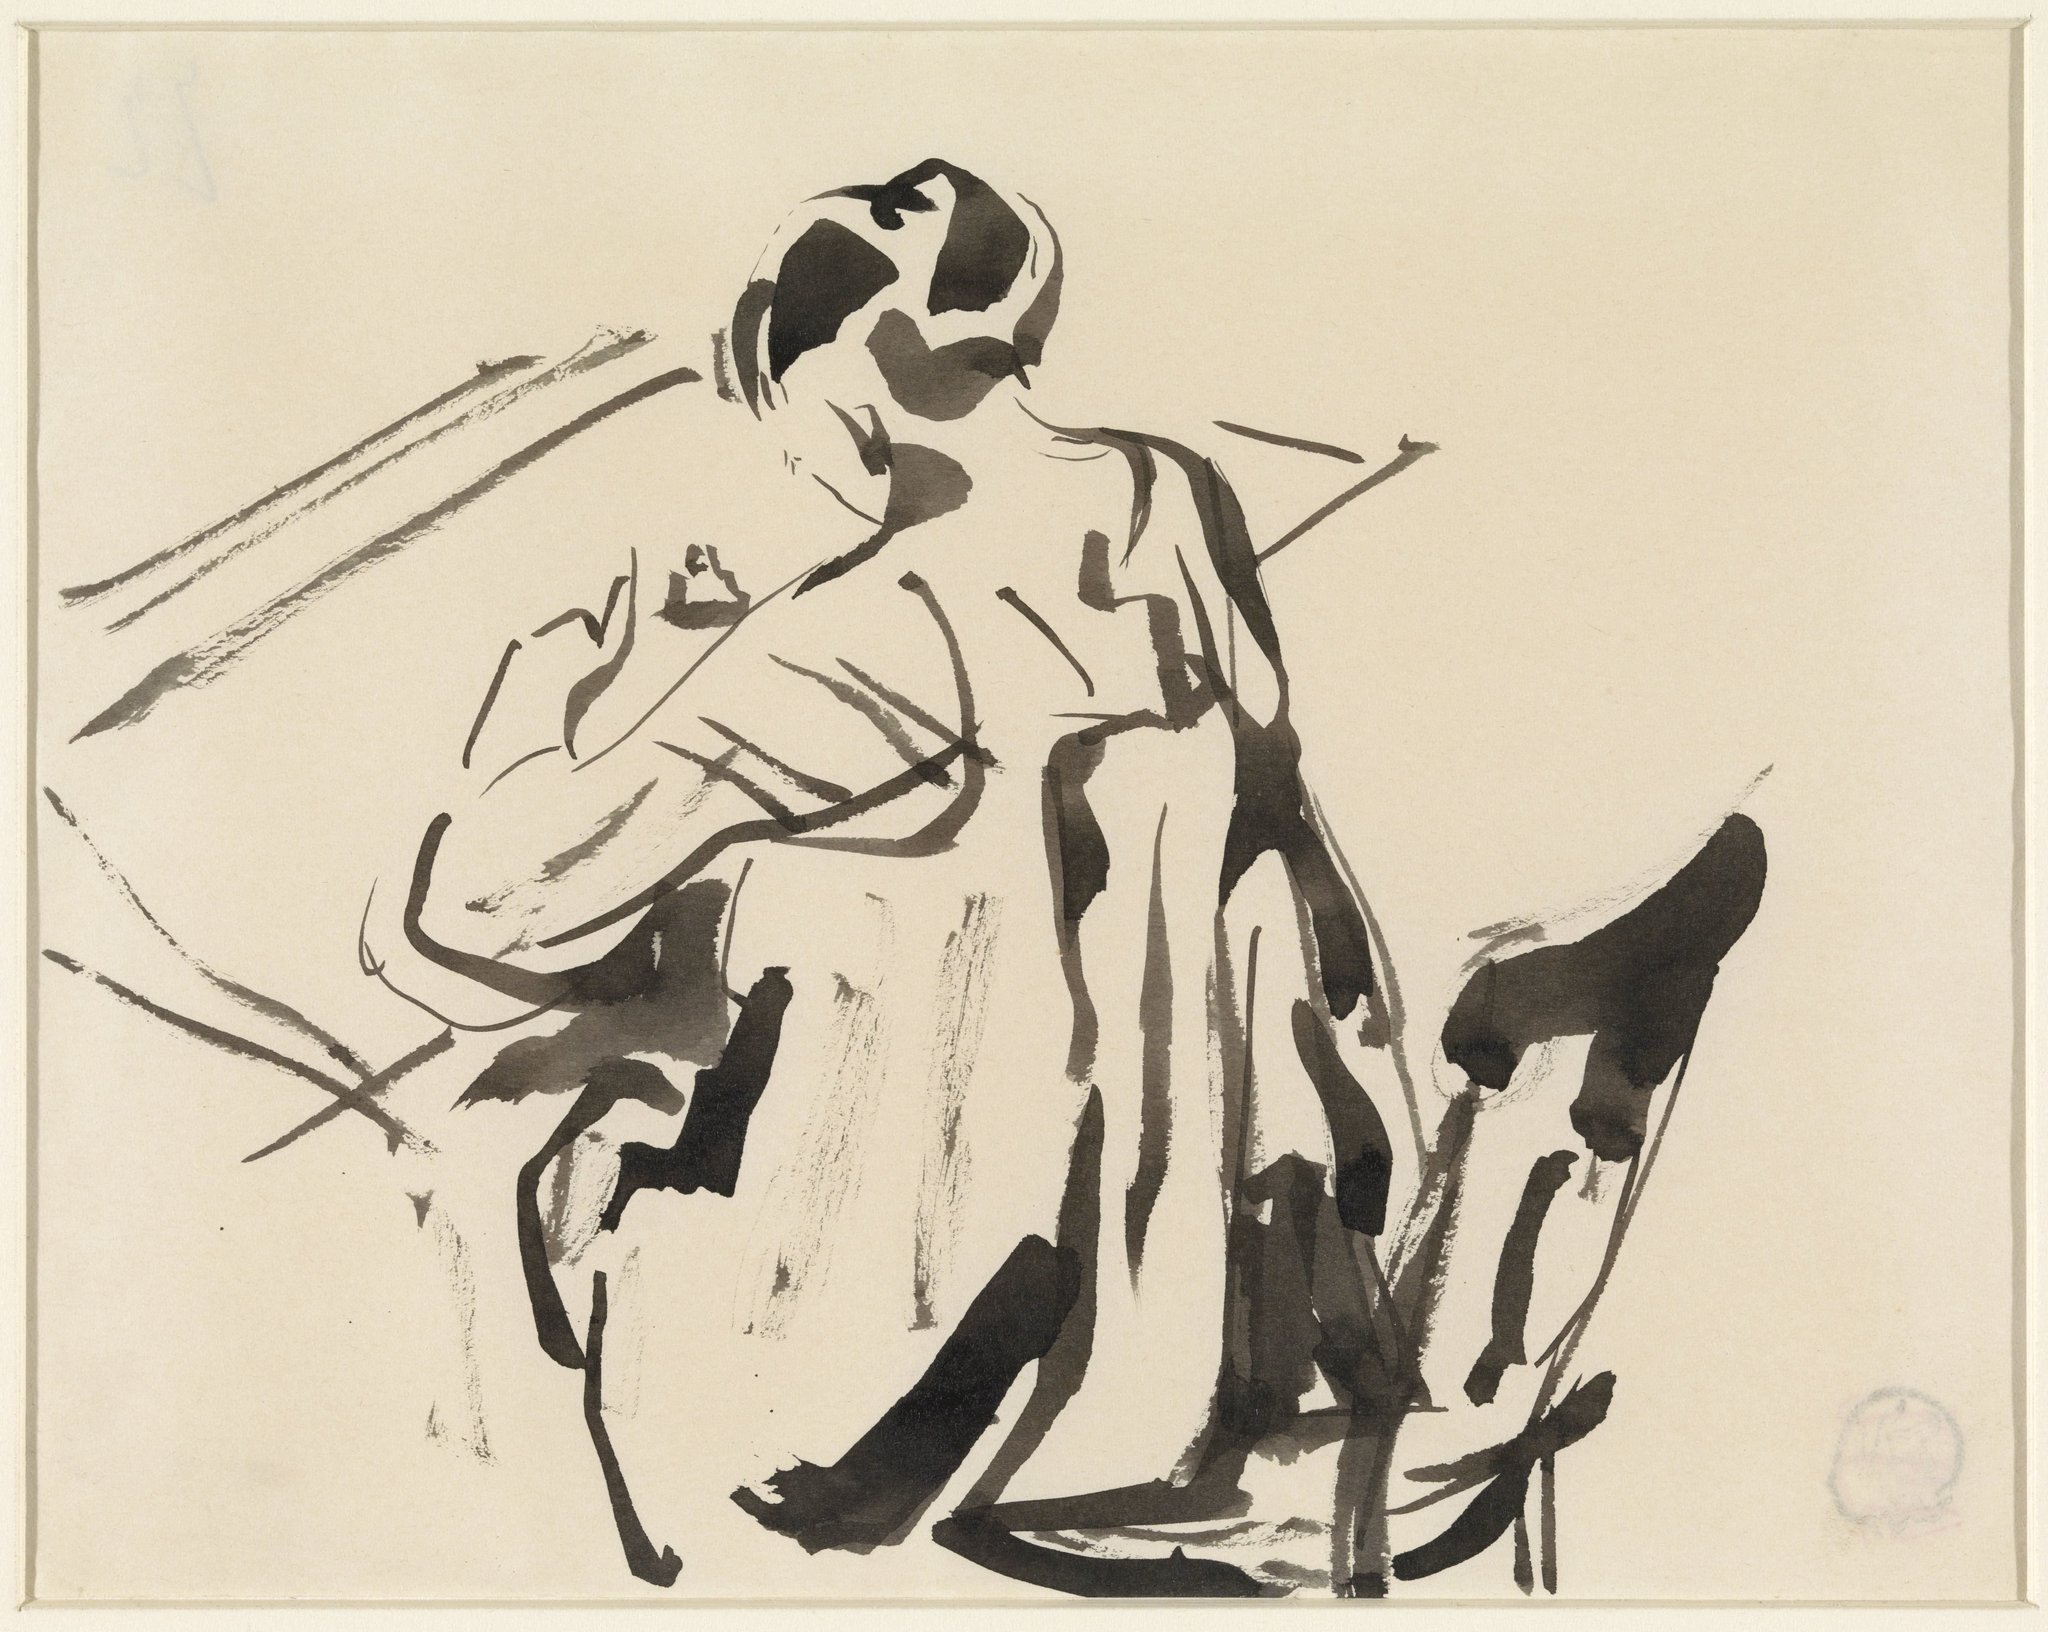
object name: drawing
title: Schrijvende vrouw, op de rug gezien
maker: rik wouters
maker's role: draughtsman, print maker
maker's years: 1882-1916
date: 1892-1916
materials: paper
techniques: brush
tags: handwriting, writing as activity